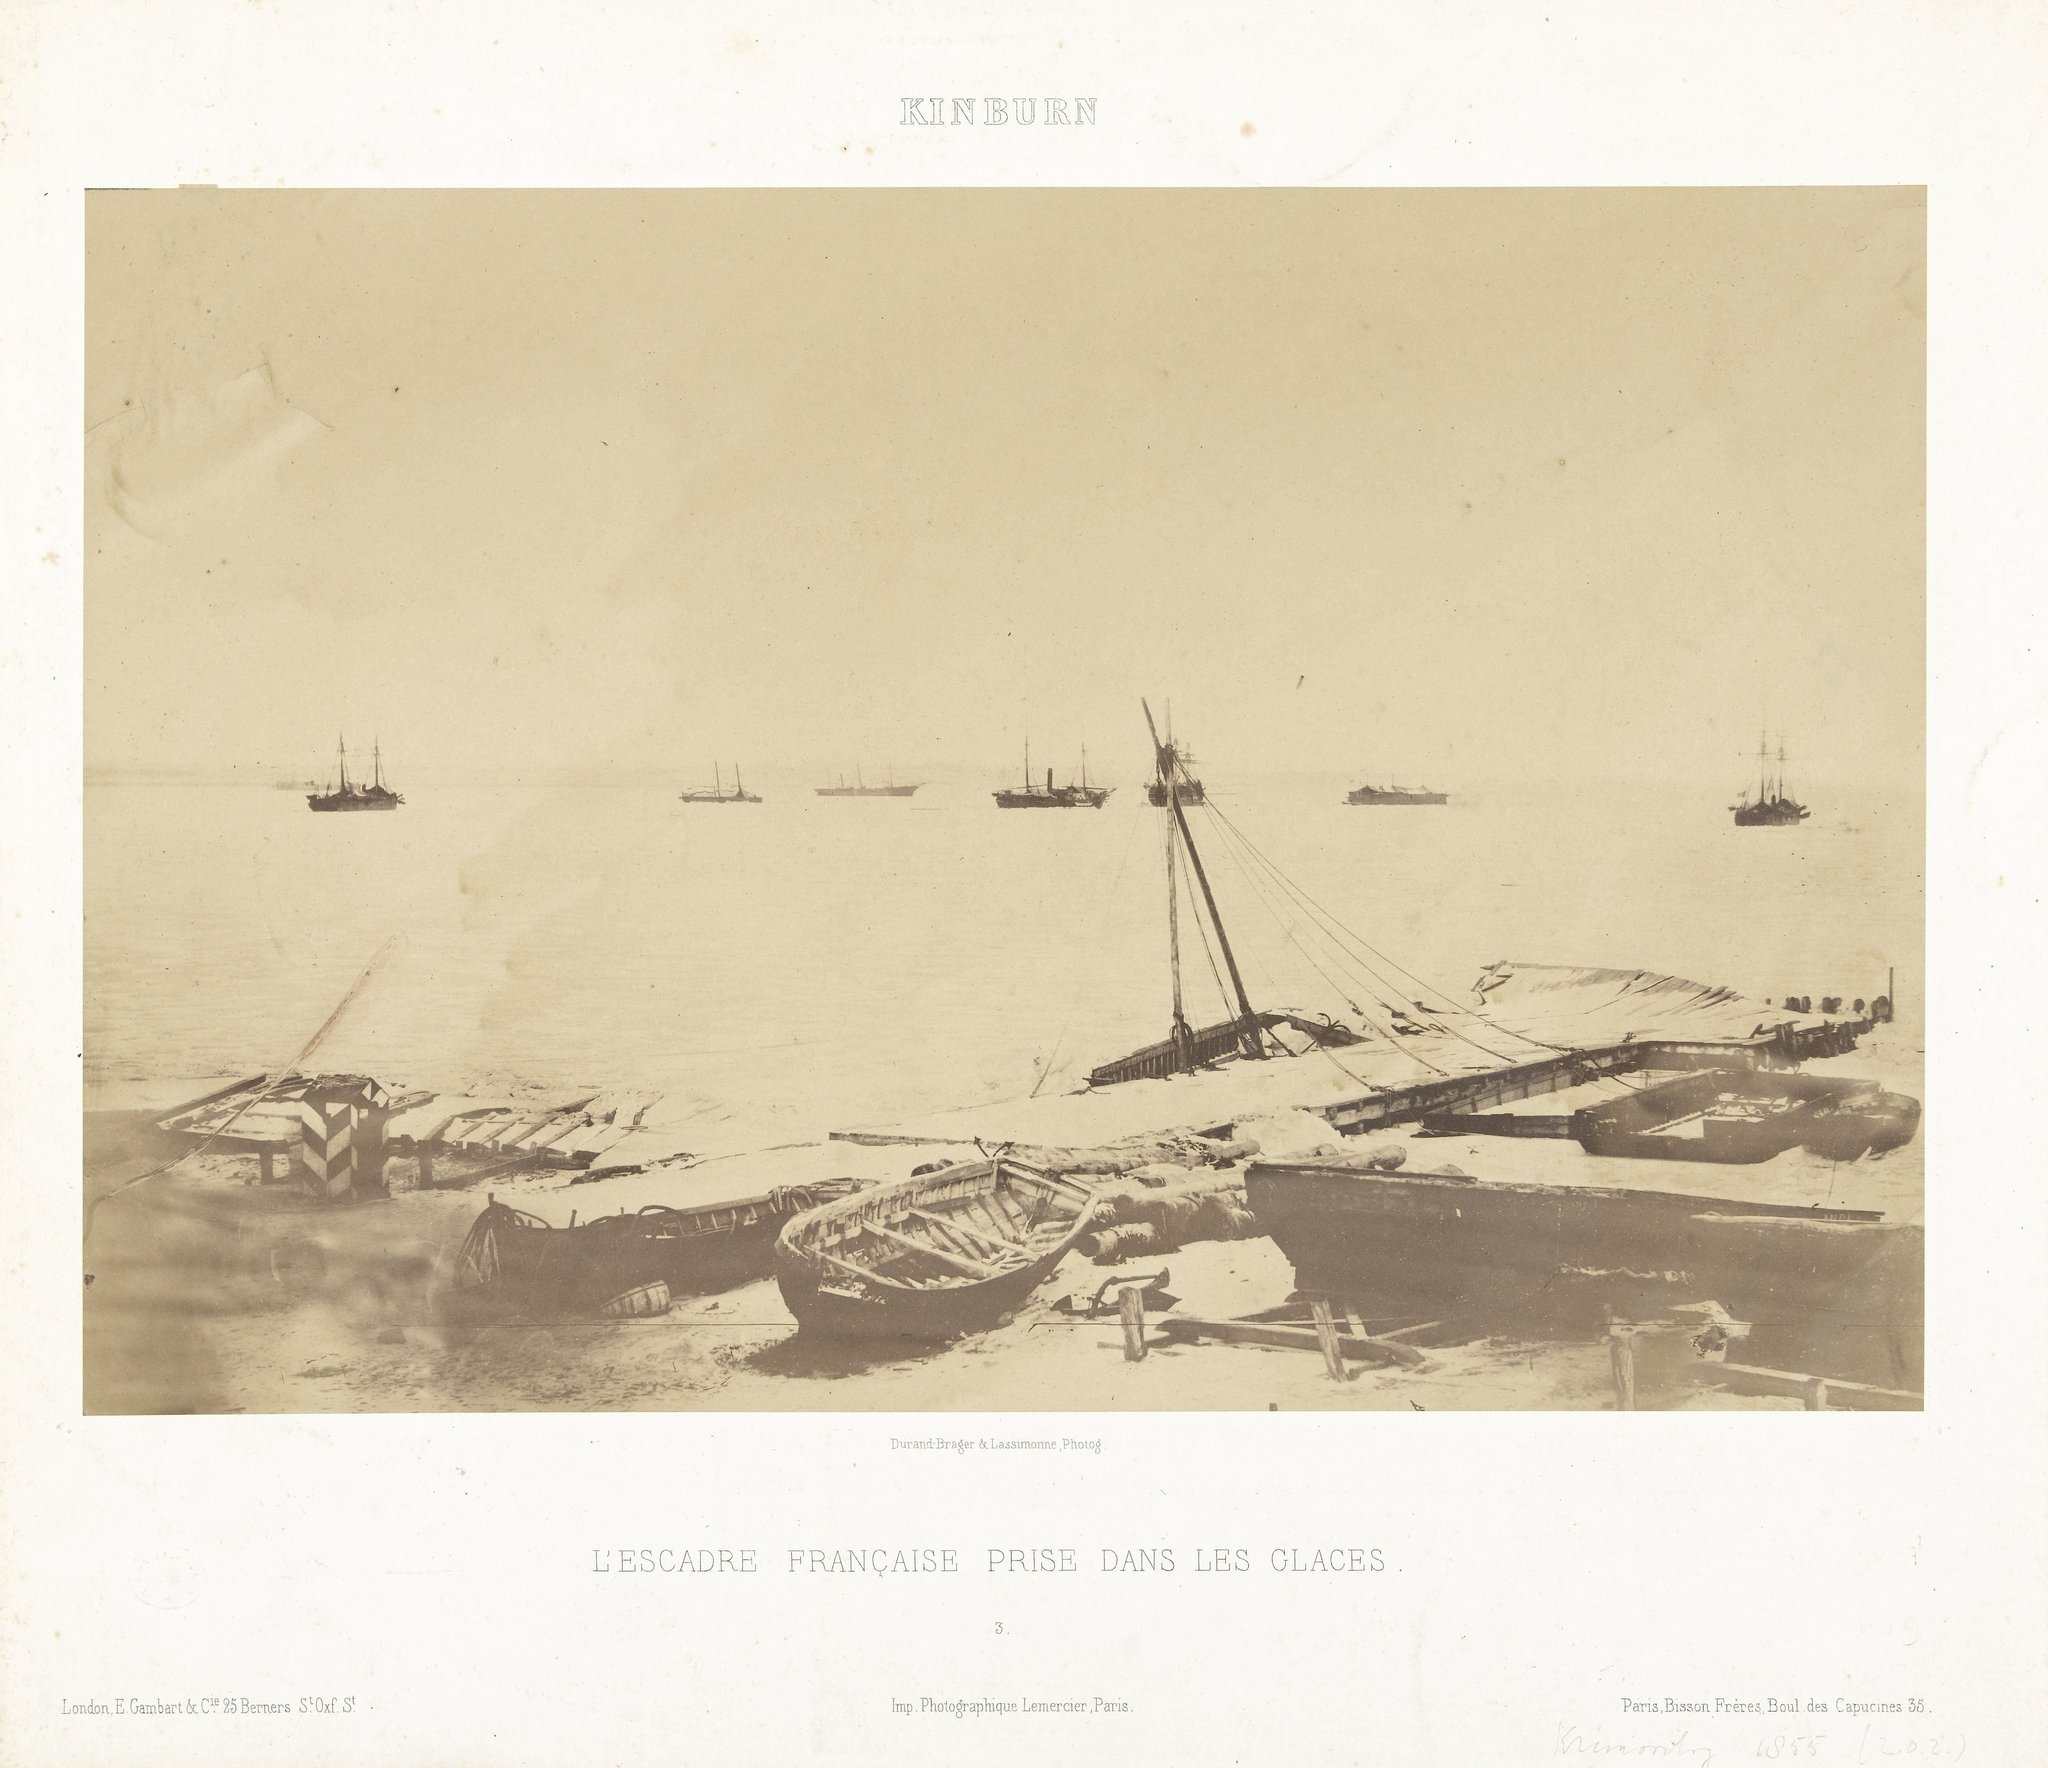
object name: photograph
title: Franse oorlogsschepen op de Dnjepr ten tijde van de Slag bij Kinboern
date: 1855-1856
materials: cardboard, paper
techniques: albumen print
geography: paris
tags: ships (in general) - cc - more than one ship, kinburn peninsula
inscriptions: number: ‘3.’